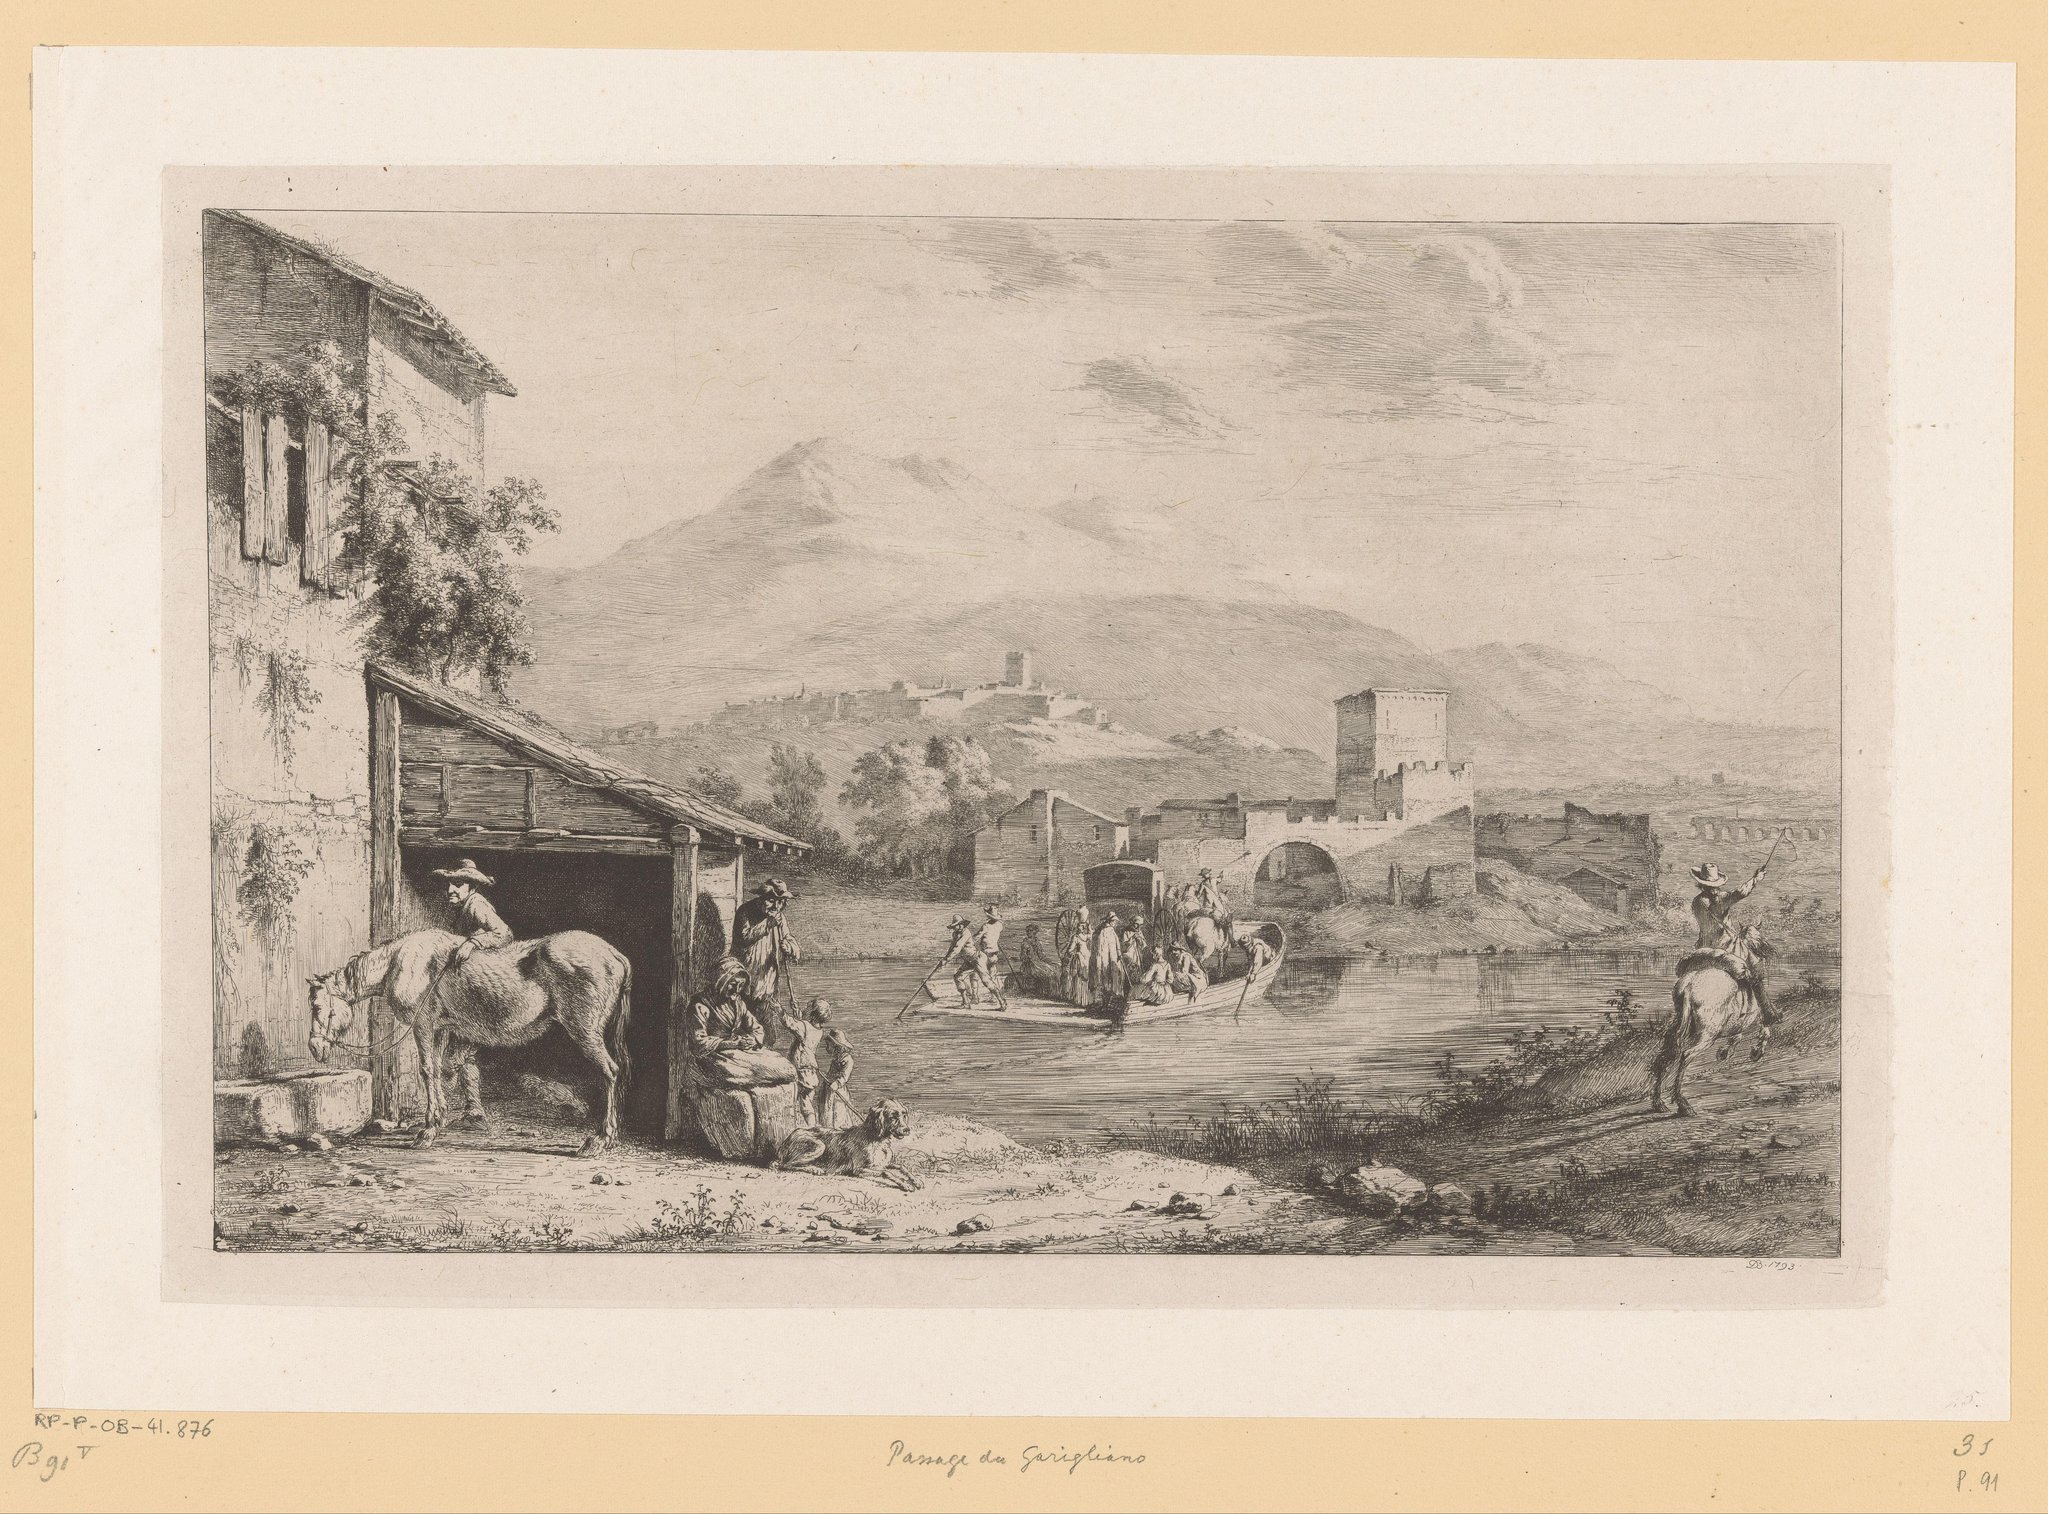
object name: print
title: Oversteekplaats aan de Carigliano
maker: jean jacques de boissieu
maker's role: draughtsman, print maker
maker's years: 1736-1810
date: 1793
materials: paper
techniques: drypoint, etching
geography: france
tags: crossing a river, landscapes with waters, waterscapes, seascapes (in the temperate zone), garigliano (river)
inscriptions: collector's mark: Lugt 12